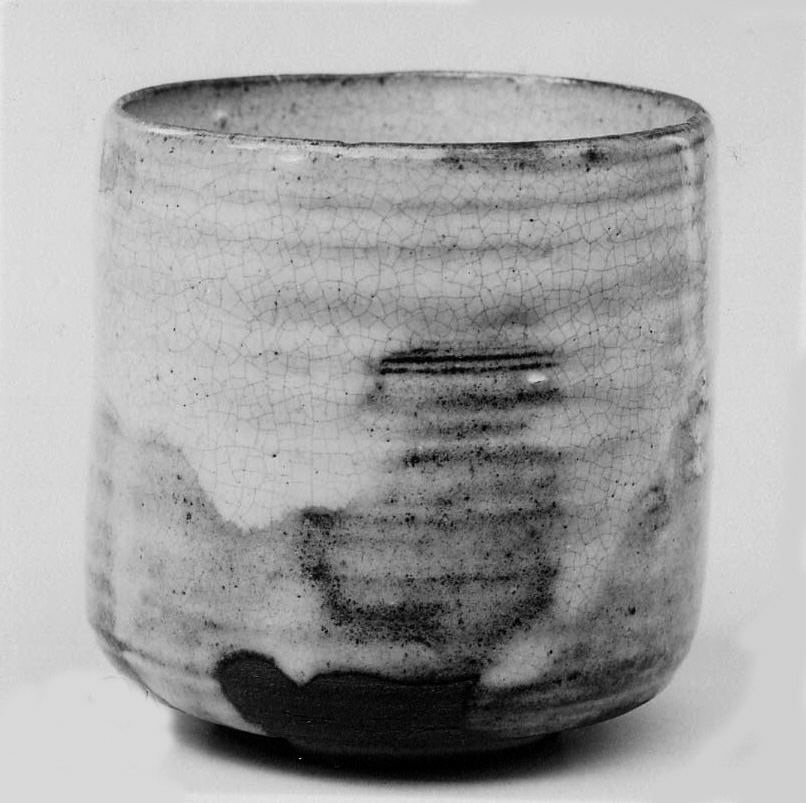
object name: teabowl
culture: japanese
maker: yōsobei i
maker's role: artist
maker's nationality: japanese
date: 1810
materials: clay, glaze